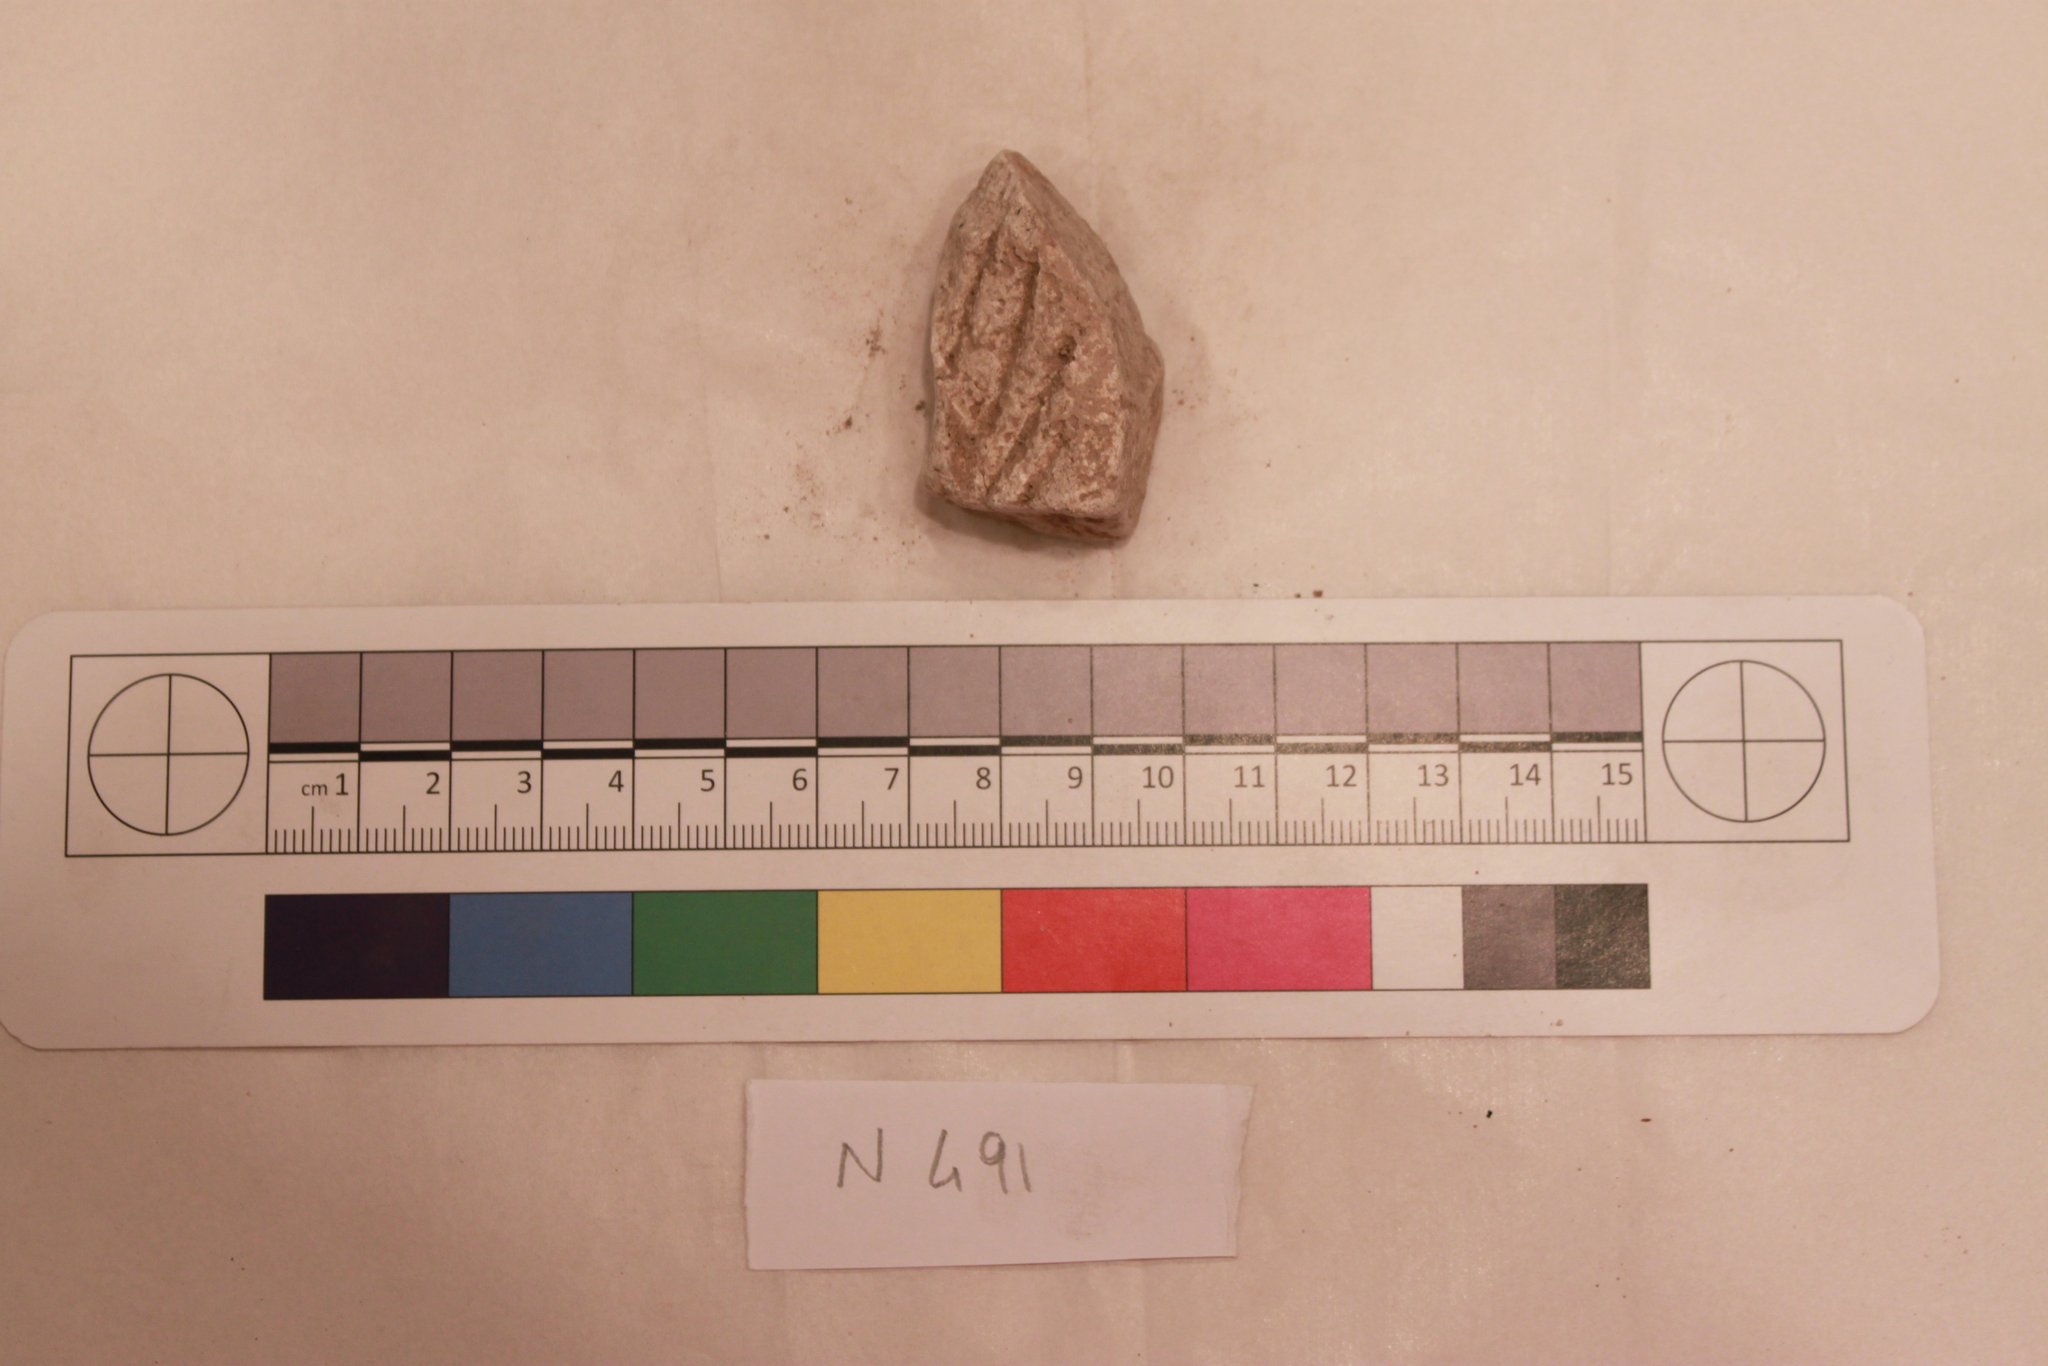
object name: fragment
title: Stucco Fragment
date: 701-1200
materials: plaster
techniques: carving, painting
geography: iran